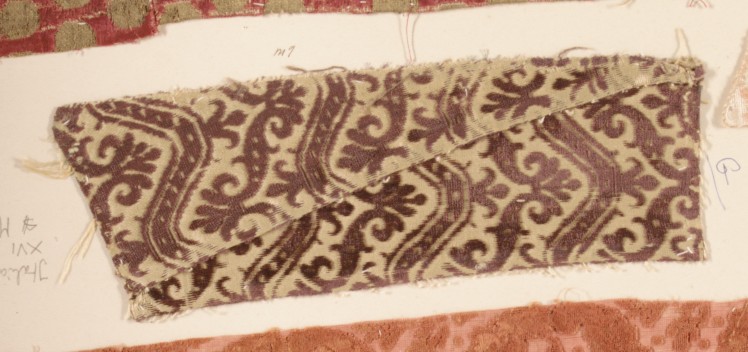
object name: fragment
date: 1567-1600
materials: silk